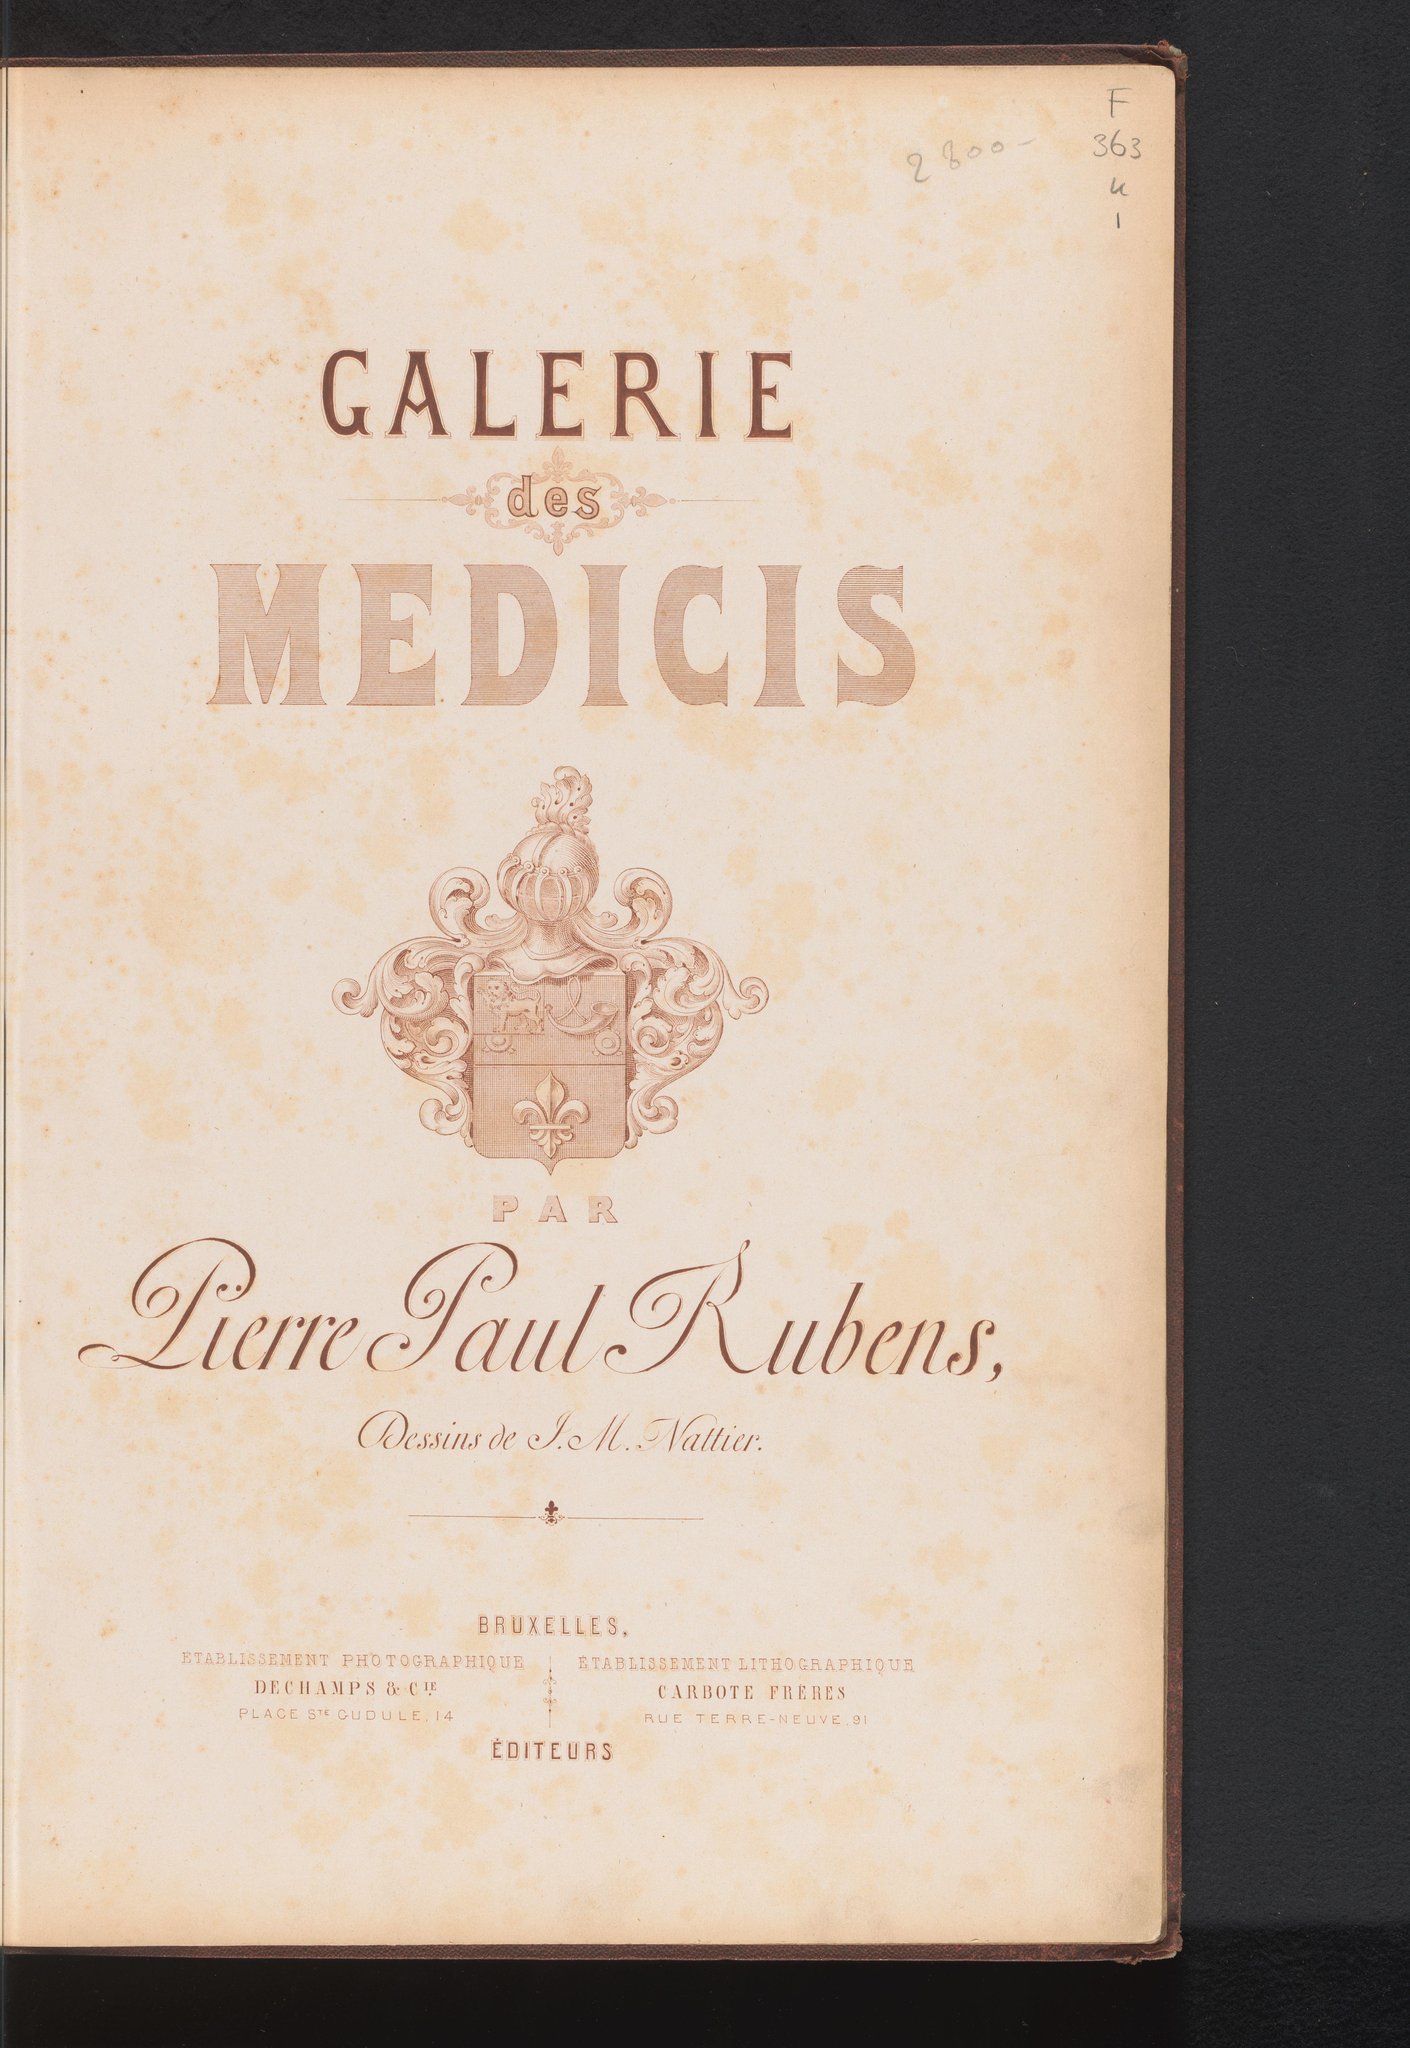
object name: book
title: Galerie des Medicis par Pierre Paul Rubens / dessins de J.M. Nattier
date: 1864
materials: cardboard, linen, paper, photographic support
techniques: albumen print, printing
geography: brussels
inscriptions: number: ‘2800-’, date: ‘MAY/ 1989’